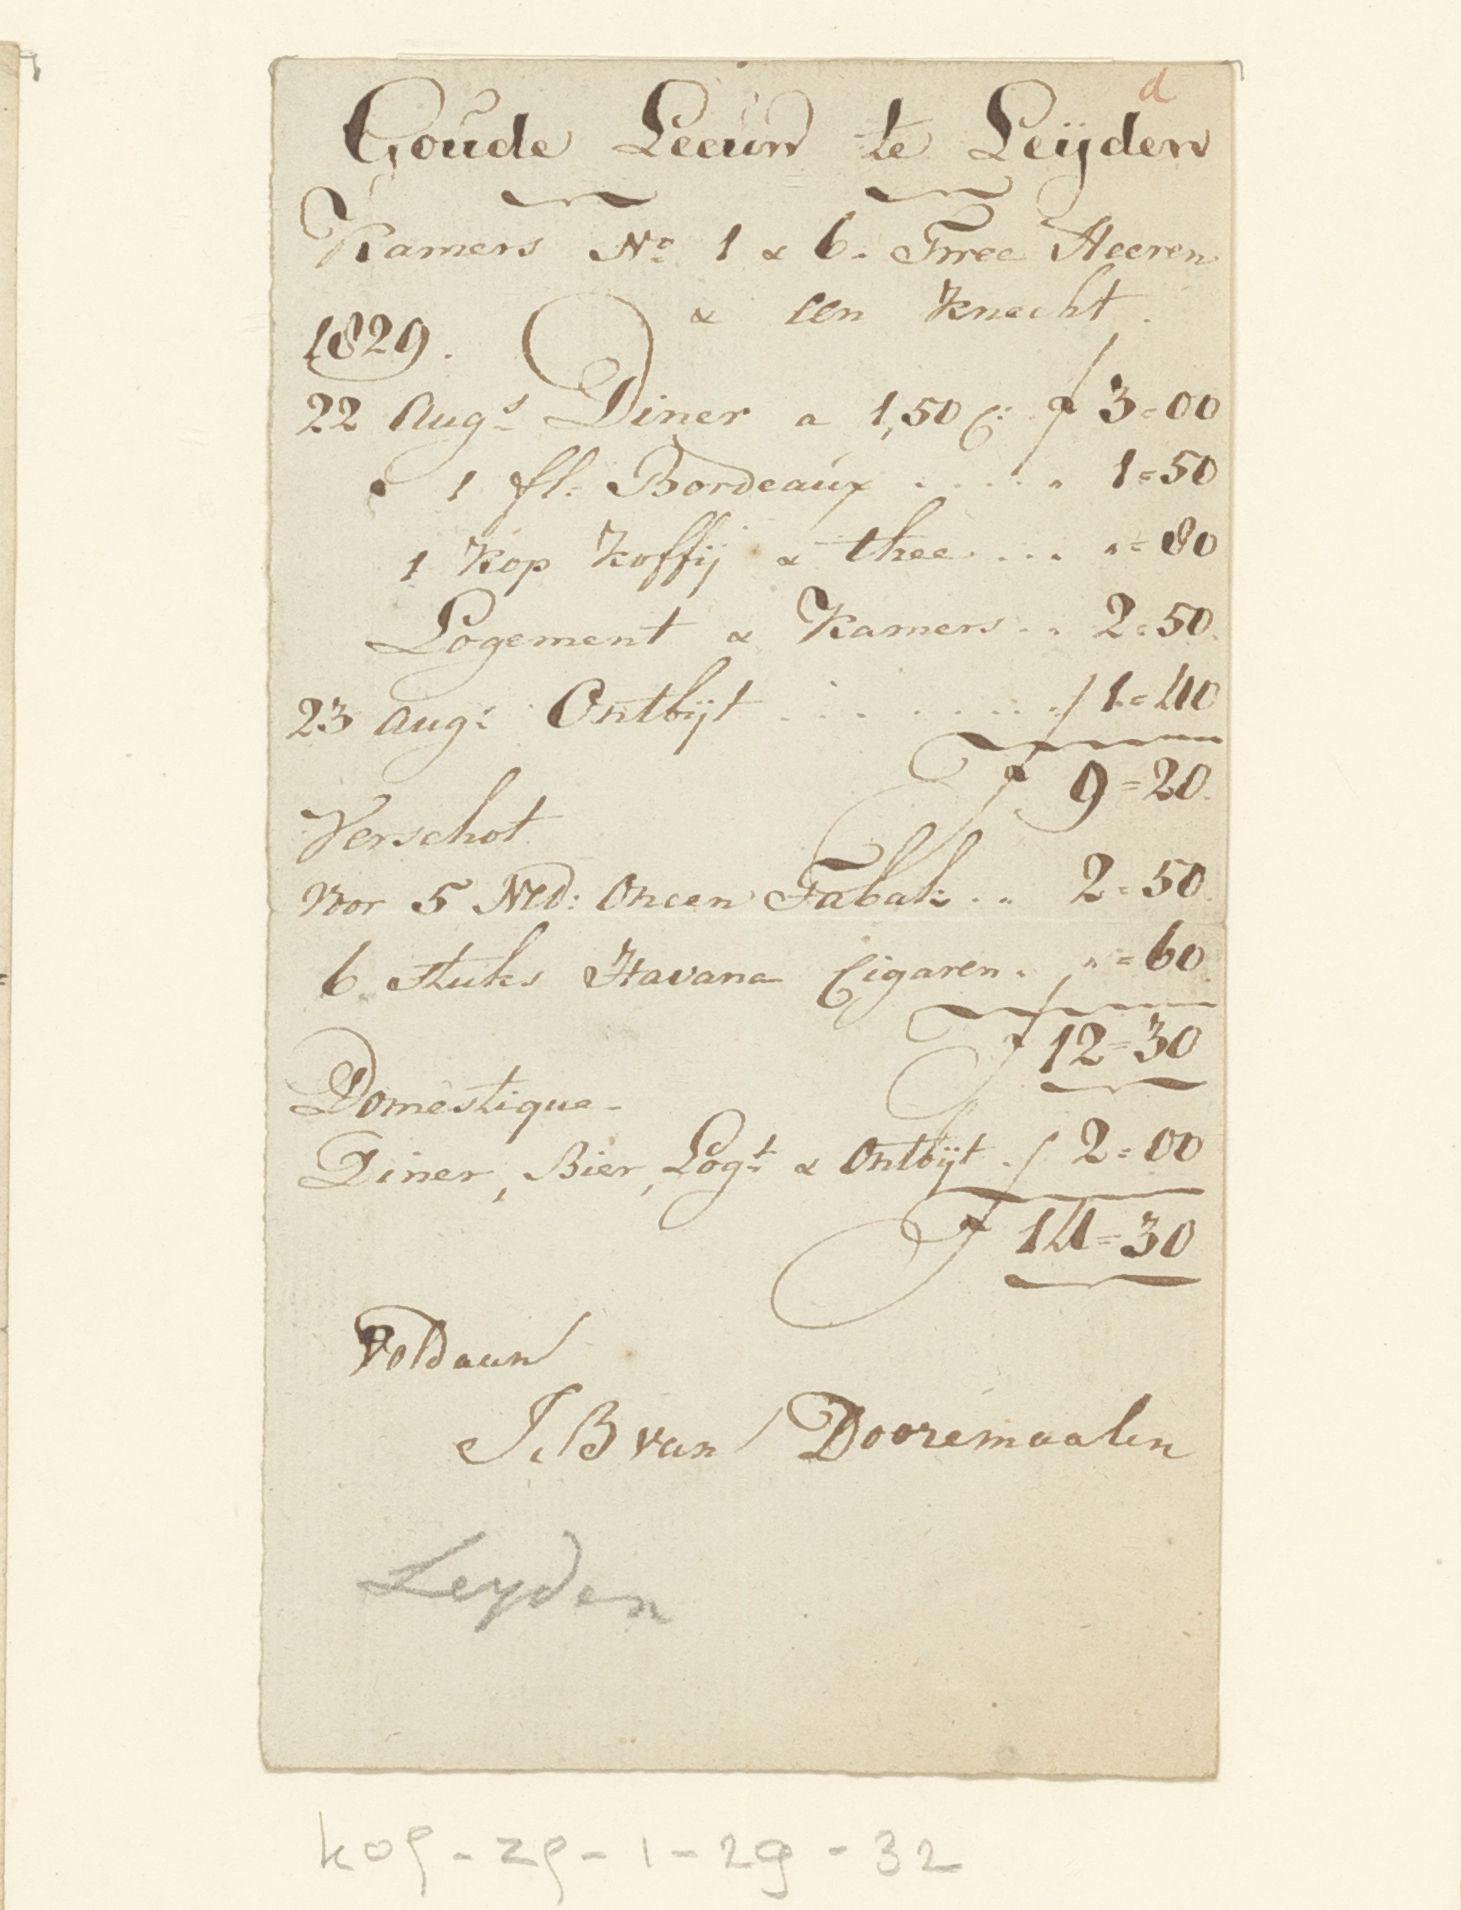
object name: account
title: Rekening voor het logement Goude Leeuw te Leiden, 1829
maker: Anonymous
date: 1829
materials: ink, paper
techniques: pen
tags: hotel, hostelry, inn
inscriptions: collector's mark: Lugt 1641, stamp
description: het logement Goude Leeuw te Leiden, 1829. Op de rekening staan de kosten voor een diner, een fles Bordeaux, koffie en thee, kamers, tabak en sigaren. Onderwerpsrubrieken binnen de Atlas Zeden en Gewoonten: Zeden en gewoonten in engeren zin, Volksleven, Uitspanningslokalen, Logementen.